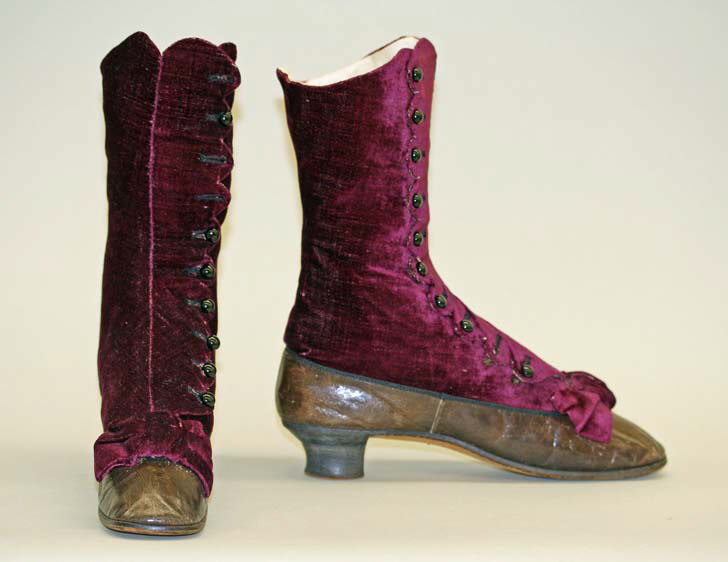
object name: boot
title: Boots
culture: american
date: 1867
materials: cotton, leather